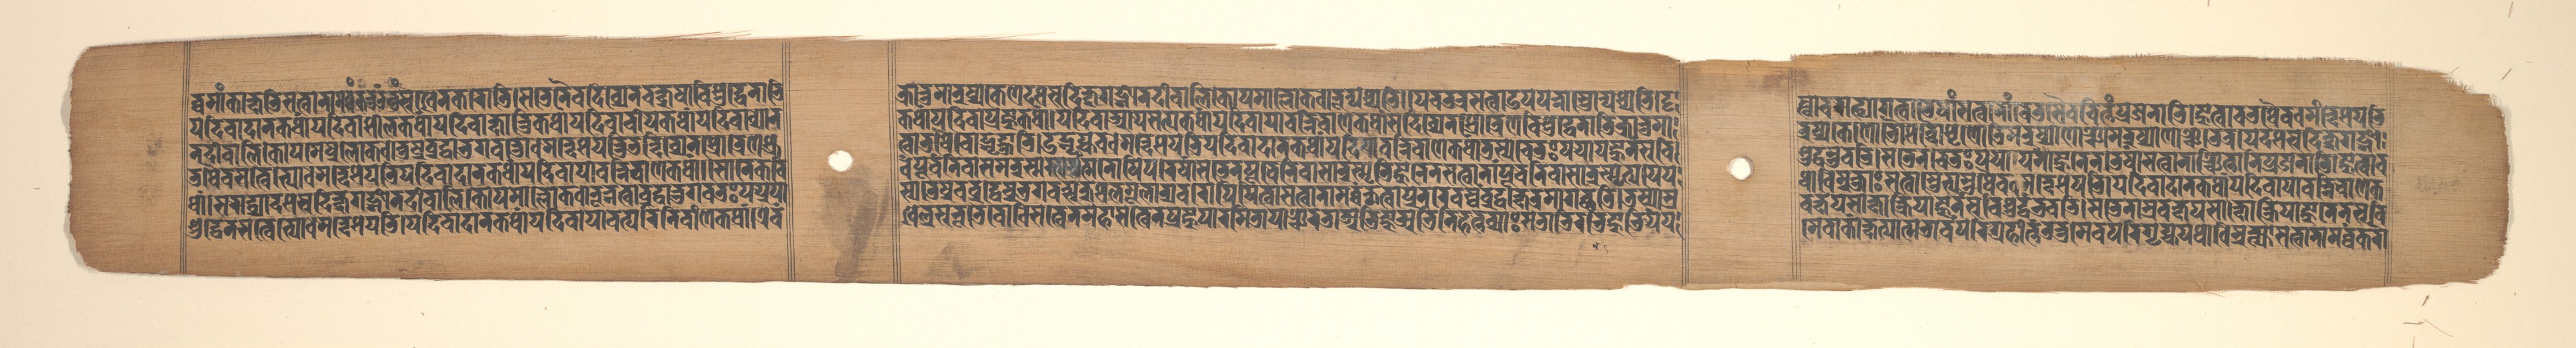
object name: folio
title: Folio from a Buddhist Manuscript of Pancavimsatisahasrika Prajnaparamita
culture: indian, bengal or bangladesh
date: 1090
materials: leaf, watercolor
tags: buddhism